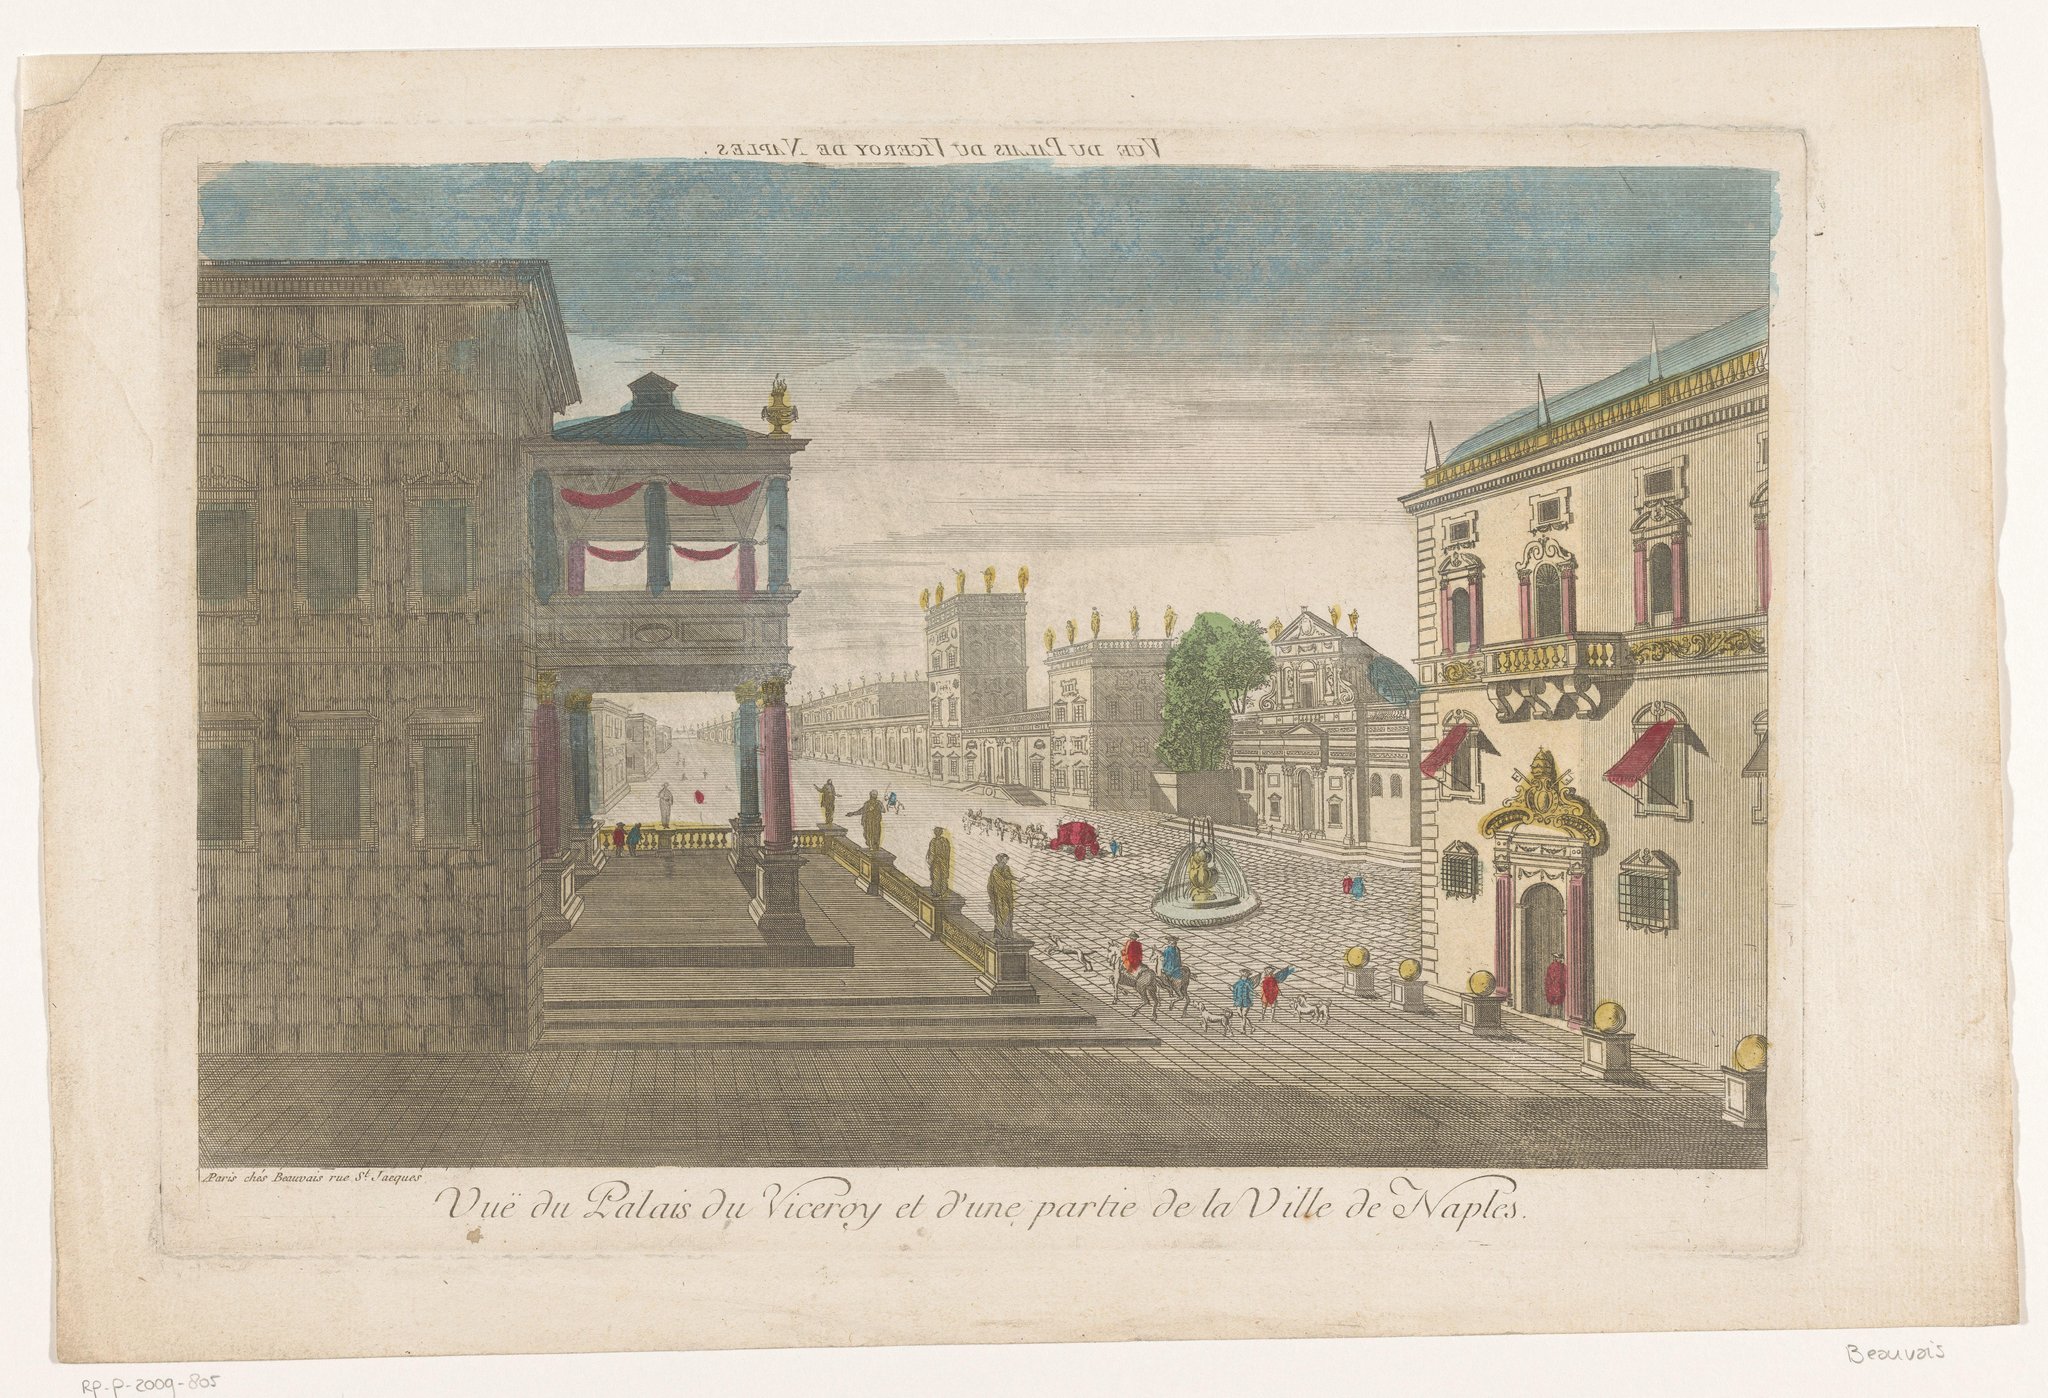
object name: print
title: Gezicht op het paleis van de onderkoning van Napels te Napels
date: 1700-1799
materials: paper, watercolor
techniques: brush, etching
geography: france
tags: palace, street (+ city(-scape) with figures, staffage), naples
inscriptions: watermark, collector's mark: Lugt 2228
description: Gezicht op een lange brede straat met grote huizen. Links een overdekt bordes met beelden op de balustrade. Op de voorgrond ruiters met honden, in het midden een fontein en een koets met zes paarden.